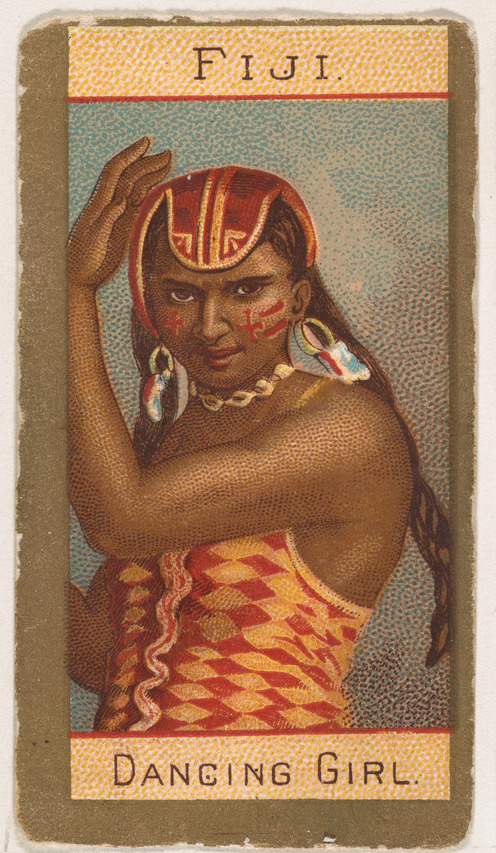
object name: print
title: Fiji, Dancing Girl, from Types of Nationalities (N240) issued by Kinney Bros.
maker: kinney brothers tobacco company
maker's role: publisher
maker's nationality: american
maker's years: 1869-2011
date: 1890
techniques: color lithograph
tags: dance,women